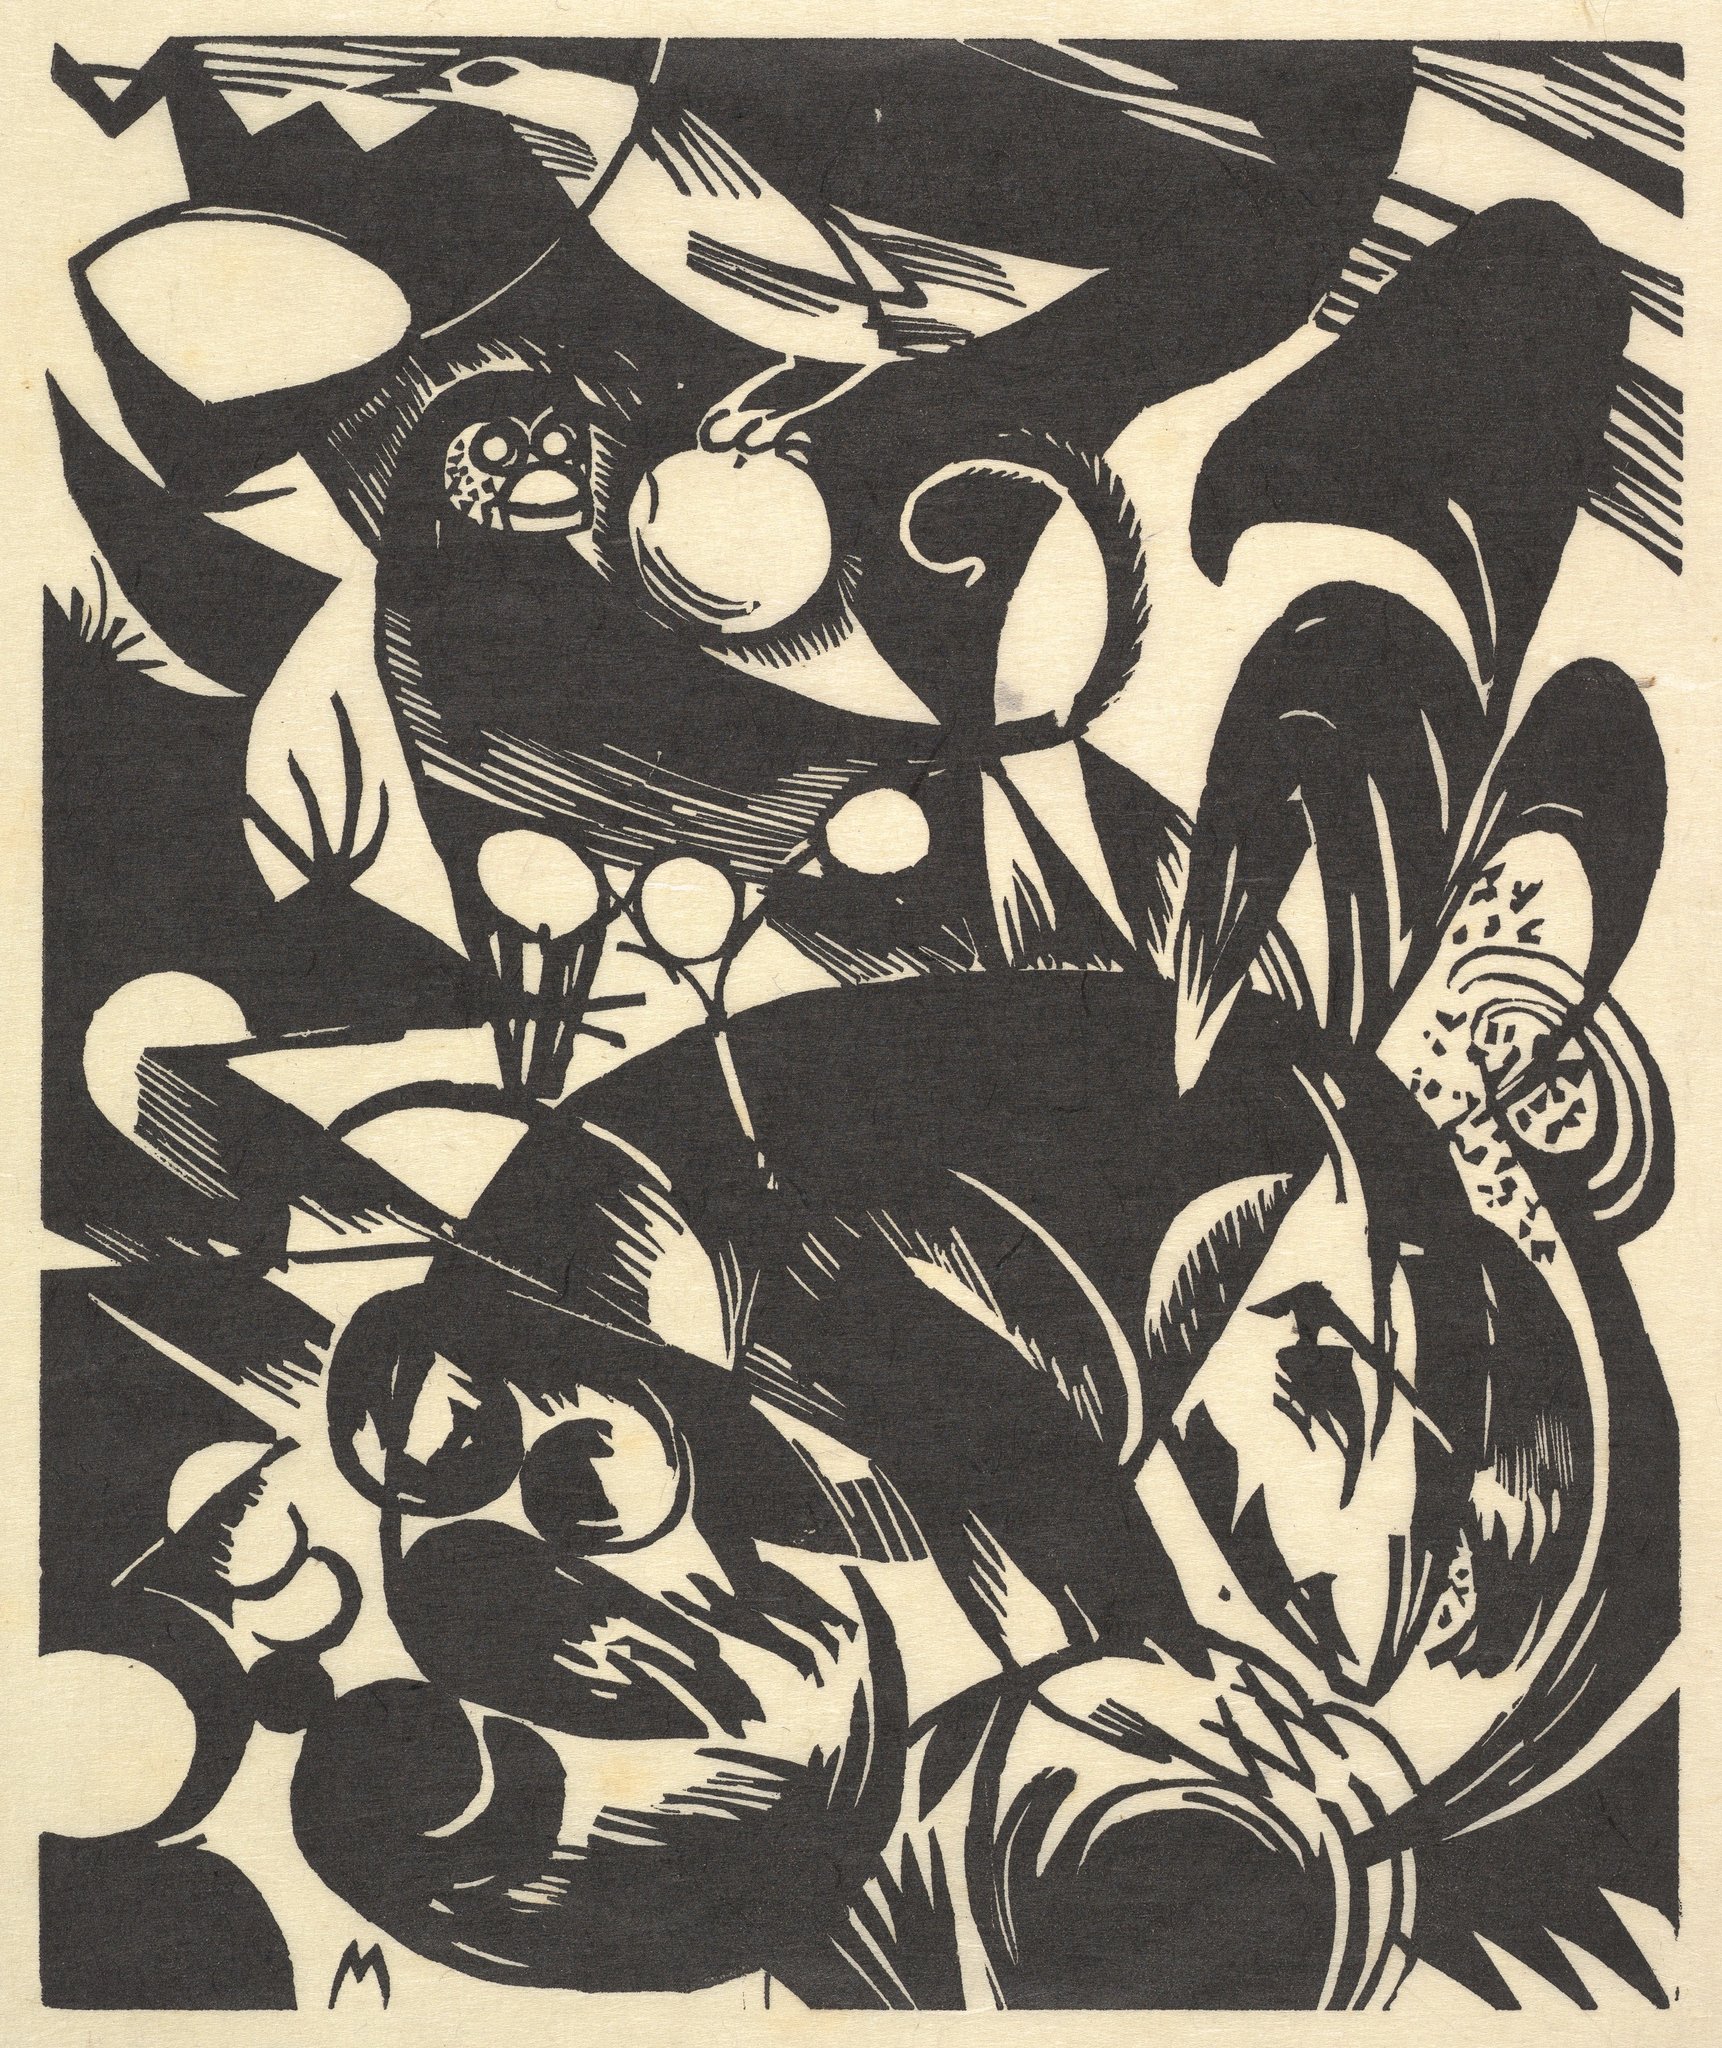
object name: print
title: Creation I from the portfolio "New European Graphics, Portfolio III: German Artists" [Schöpfungsgeschichte I from the portfolio Neue Europäische Graphik III: Deutsche Künstler]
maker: franz marc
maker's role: artist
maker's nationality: german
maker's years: 1880-1916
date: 1914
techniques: woodcut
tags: abstraction